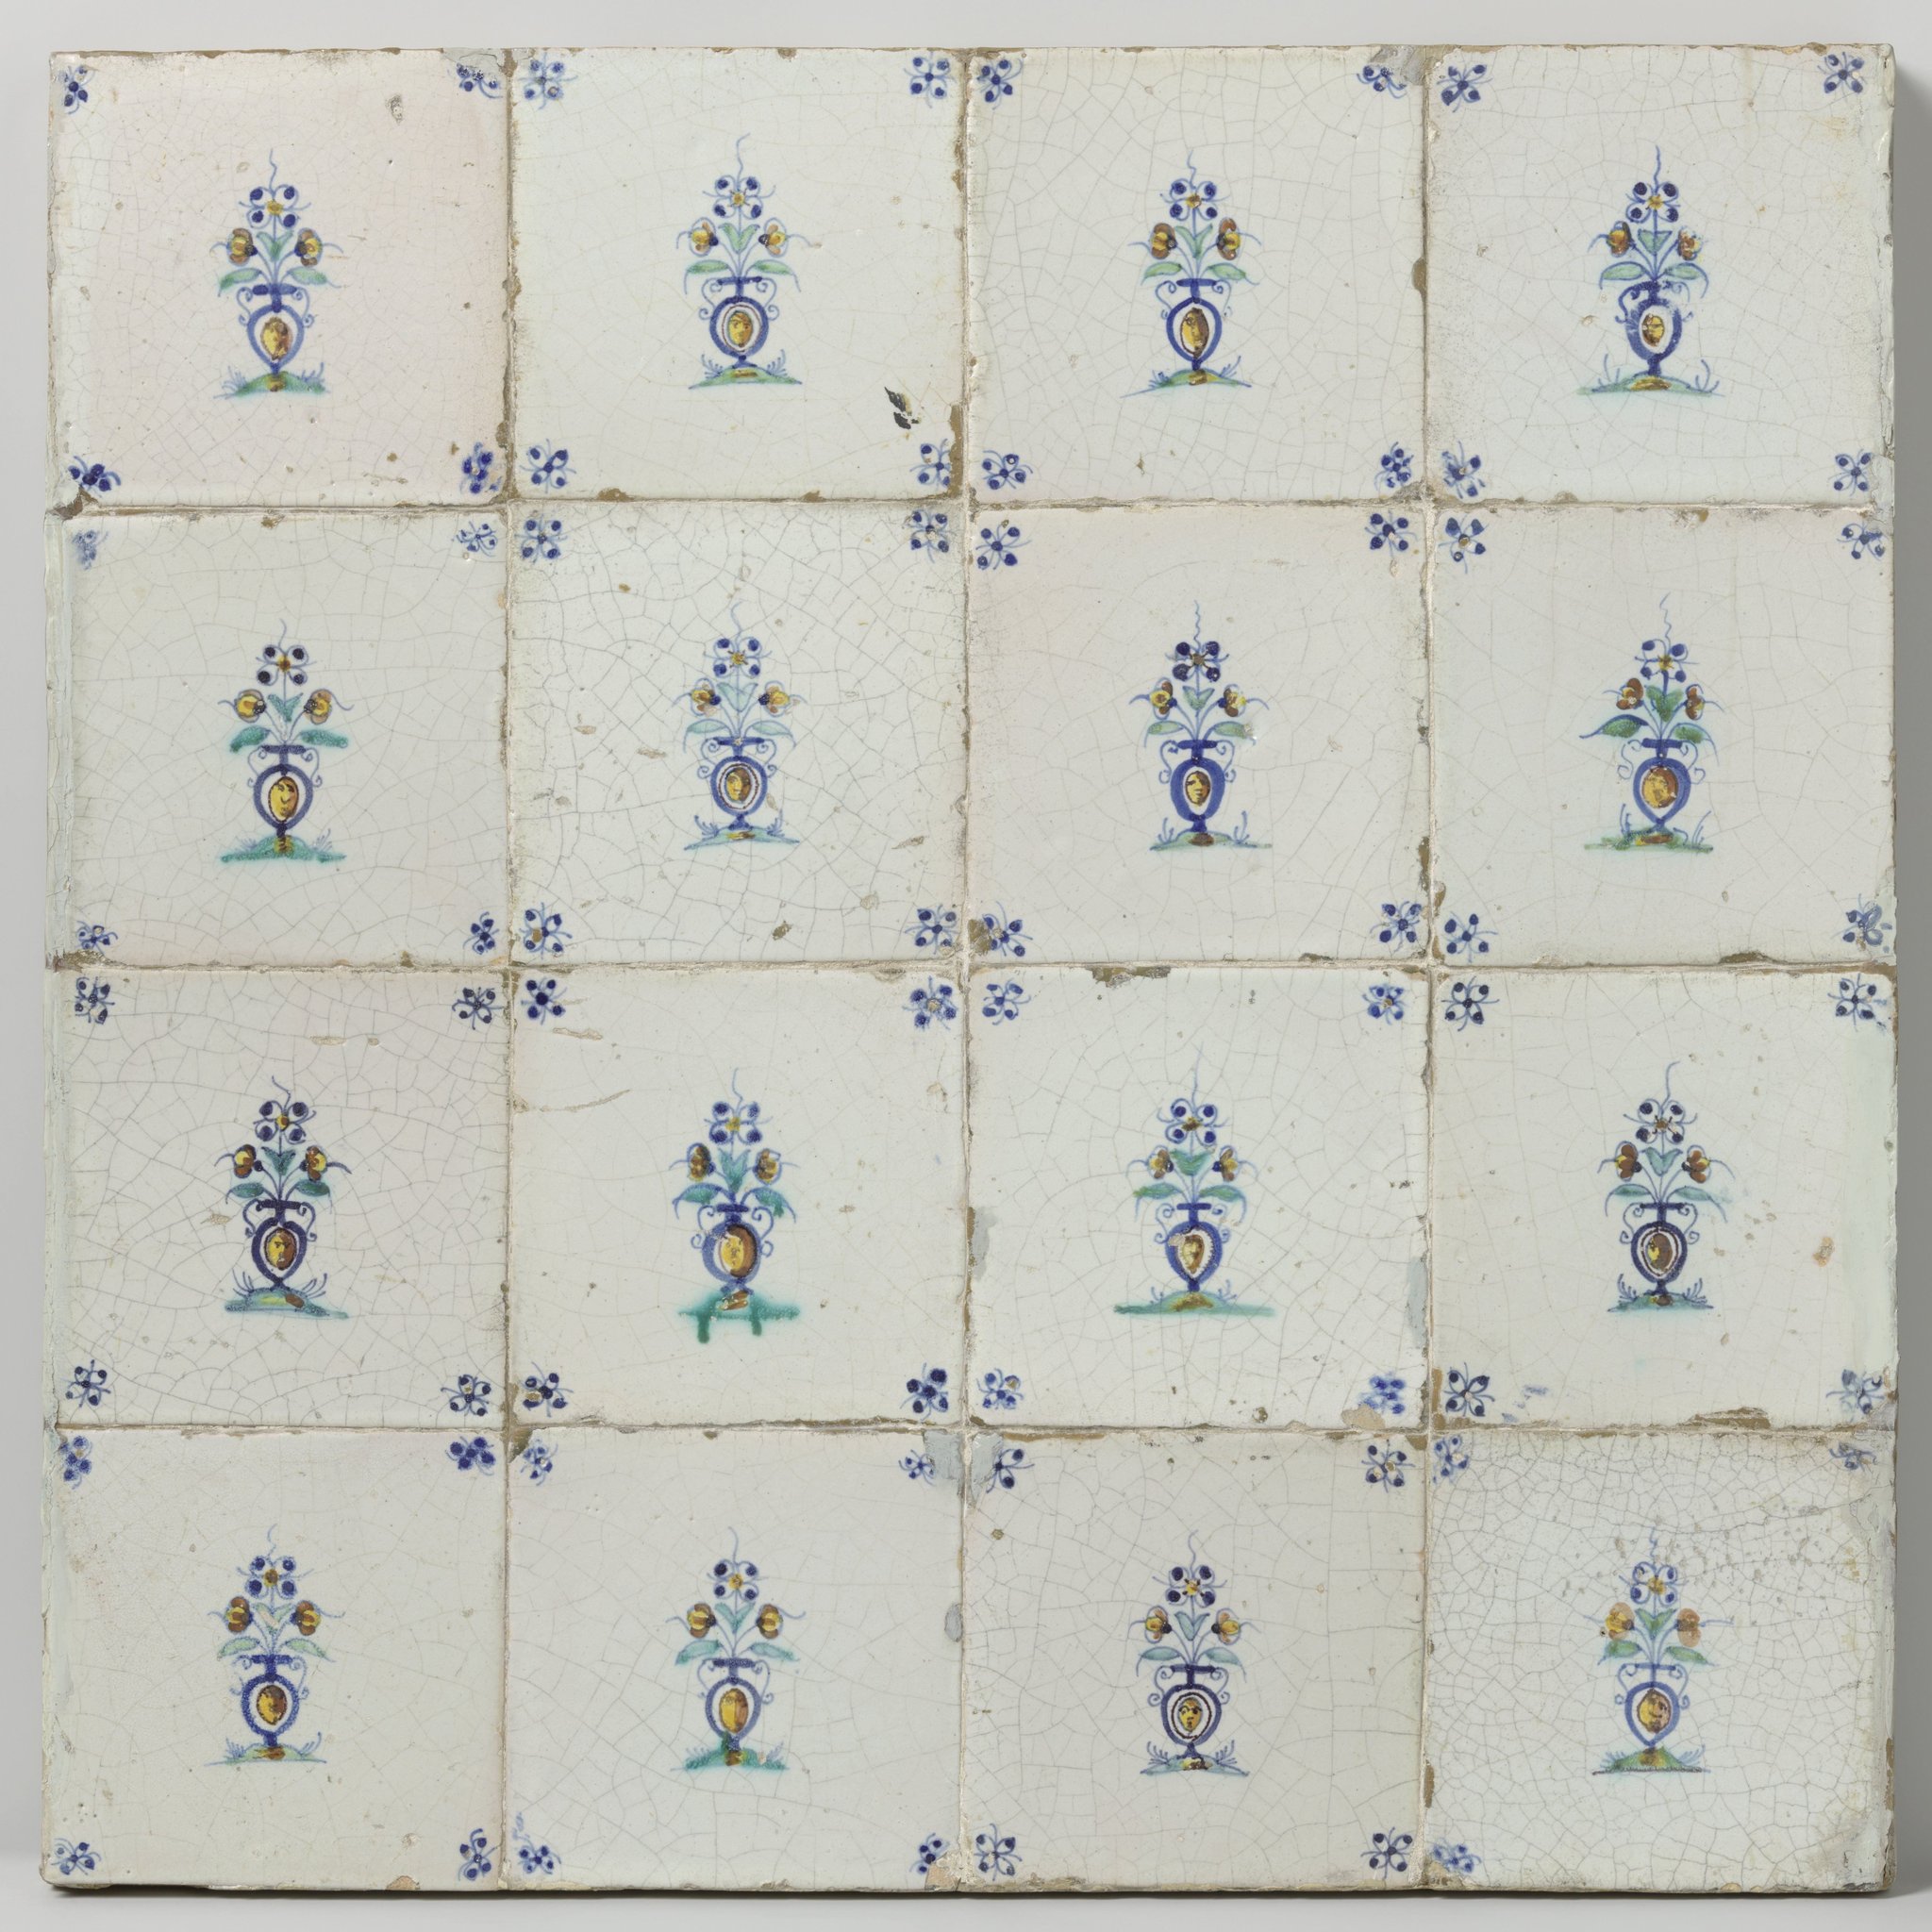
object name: tegelveld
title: Veld van zestien tegels met bloempotten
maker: Anonymous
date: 1670-1700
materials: earthenware, glaze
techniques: maiolica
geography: netherlands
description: Veld van zestien tegels (4 x 4) elk met een veelkleurig (blauw, groen, geel, oranje en paars) geschilderde bloempot. In de hoeken, een spinnetje.